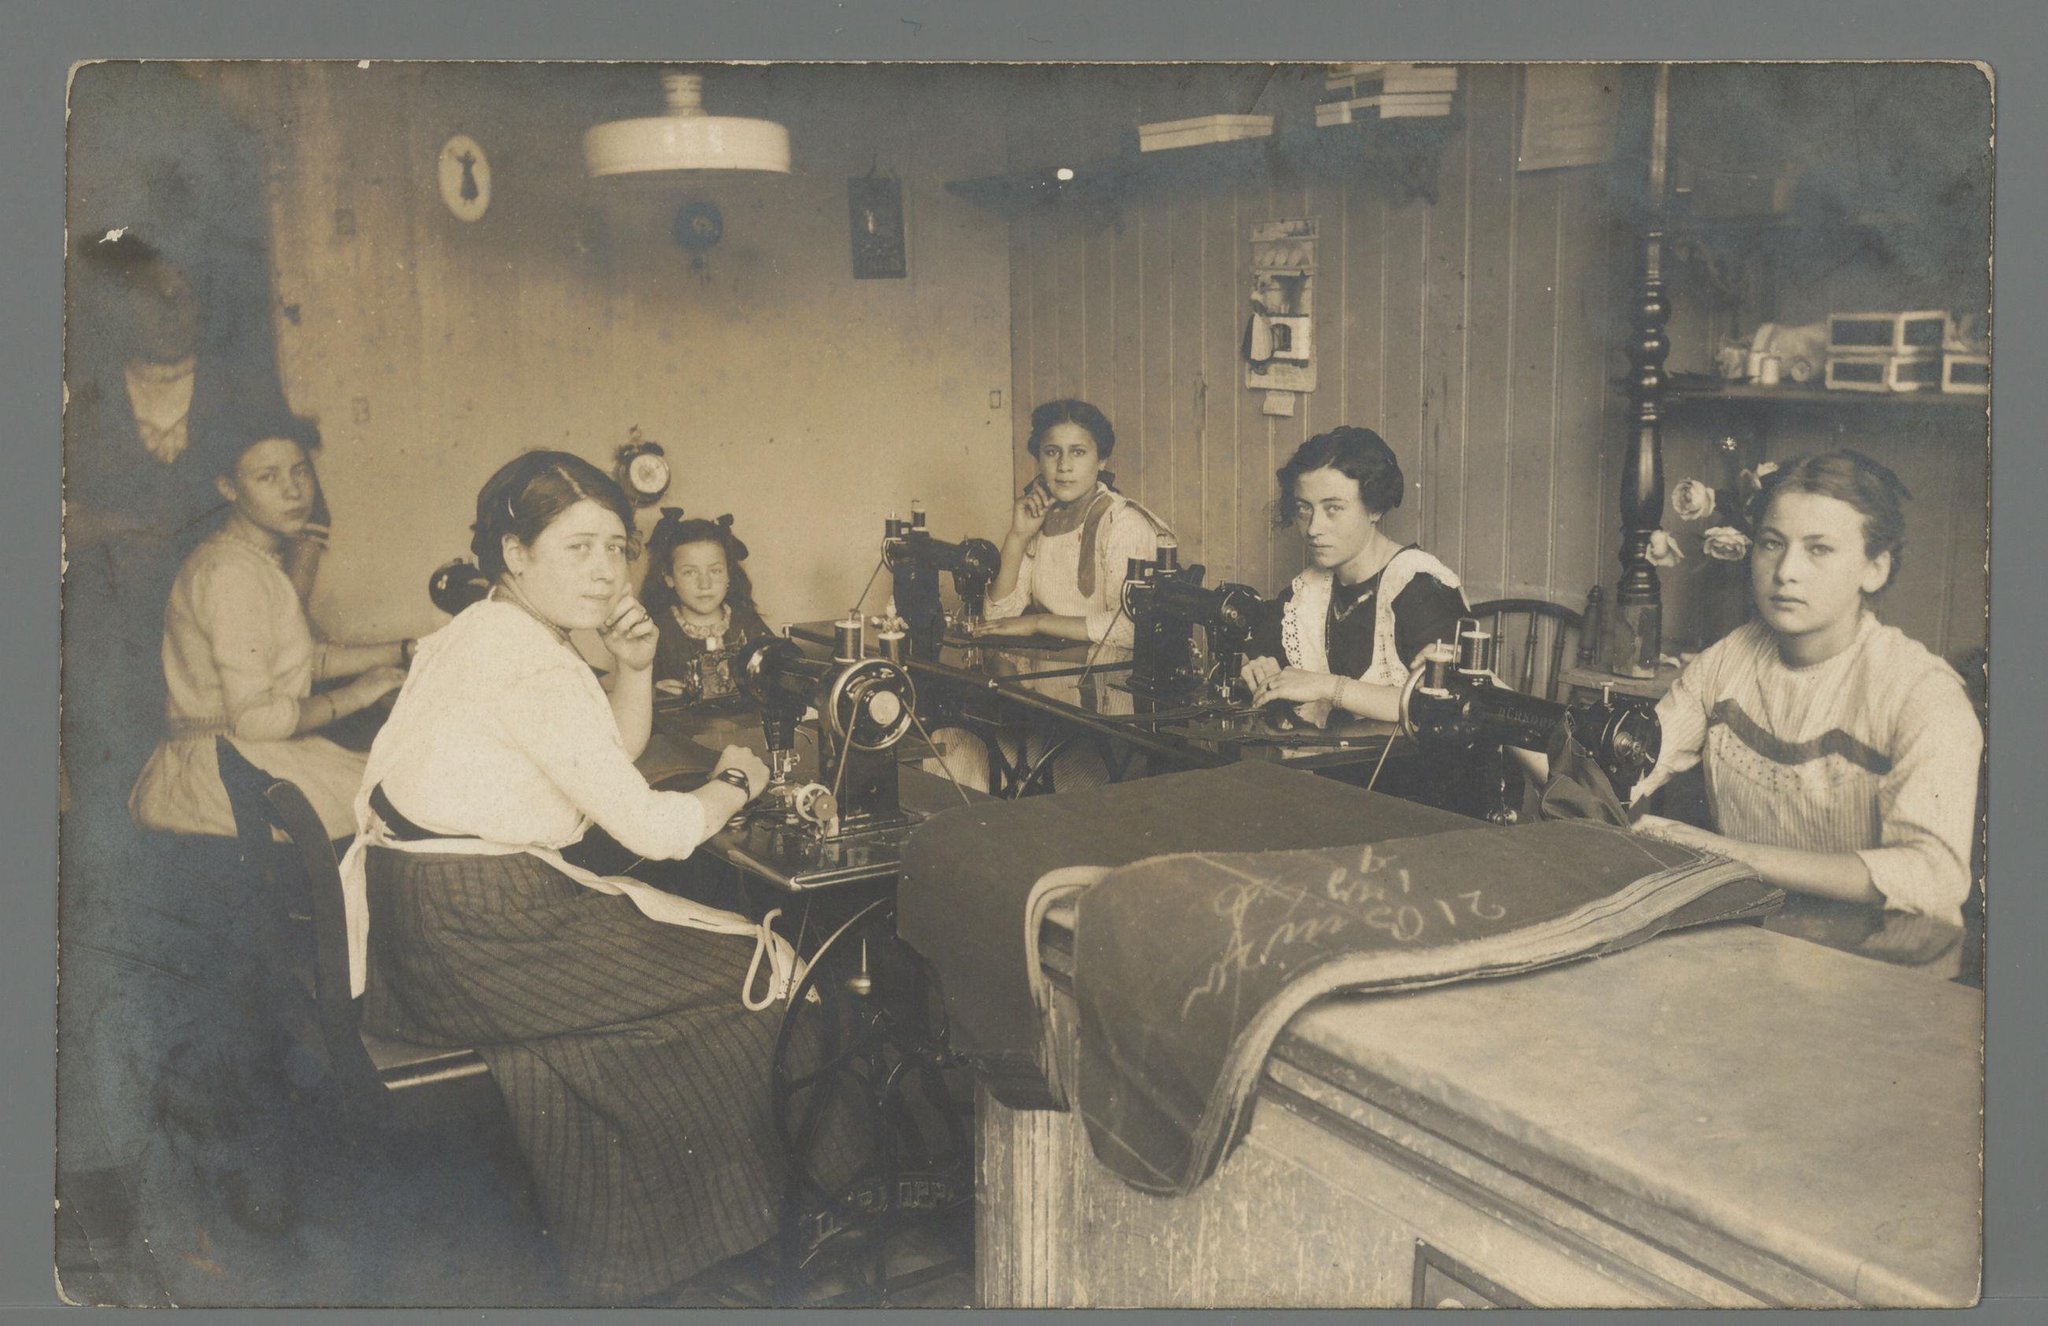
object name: photograph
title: Vrouwen aan het werk in een naaiatelier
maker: Anonymous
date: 1905-1930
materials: photographic support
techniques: photography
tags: sewing machine, tailor, dressmaker